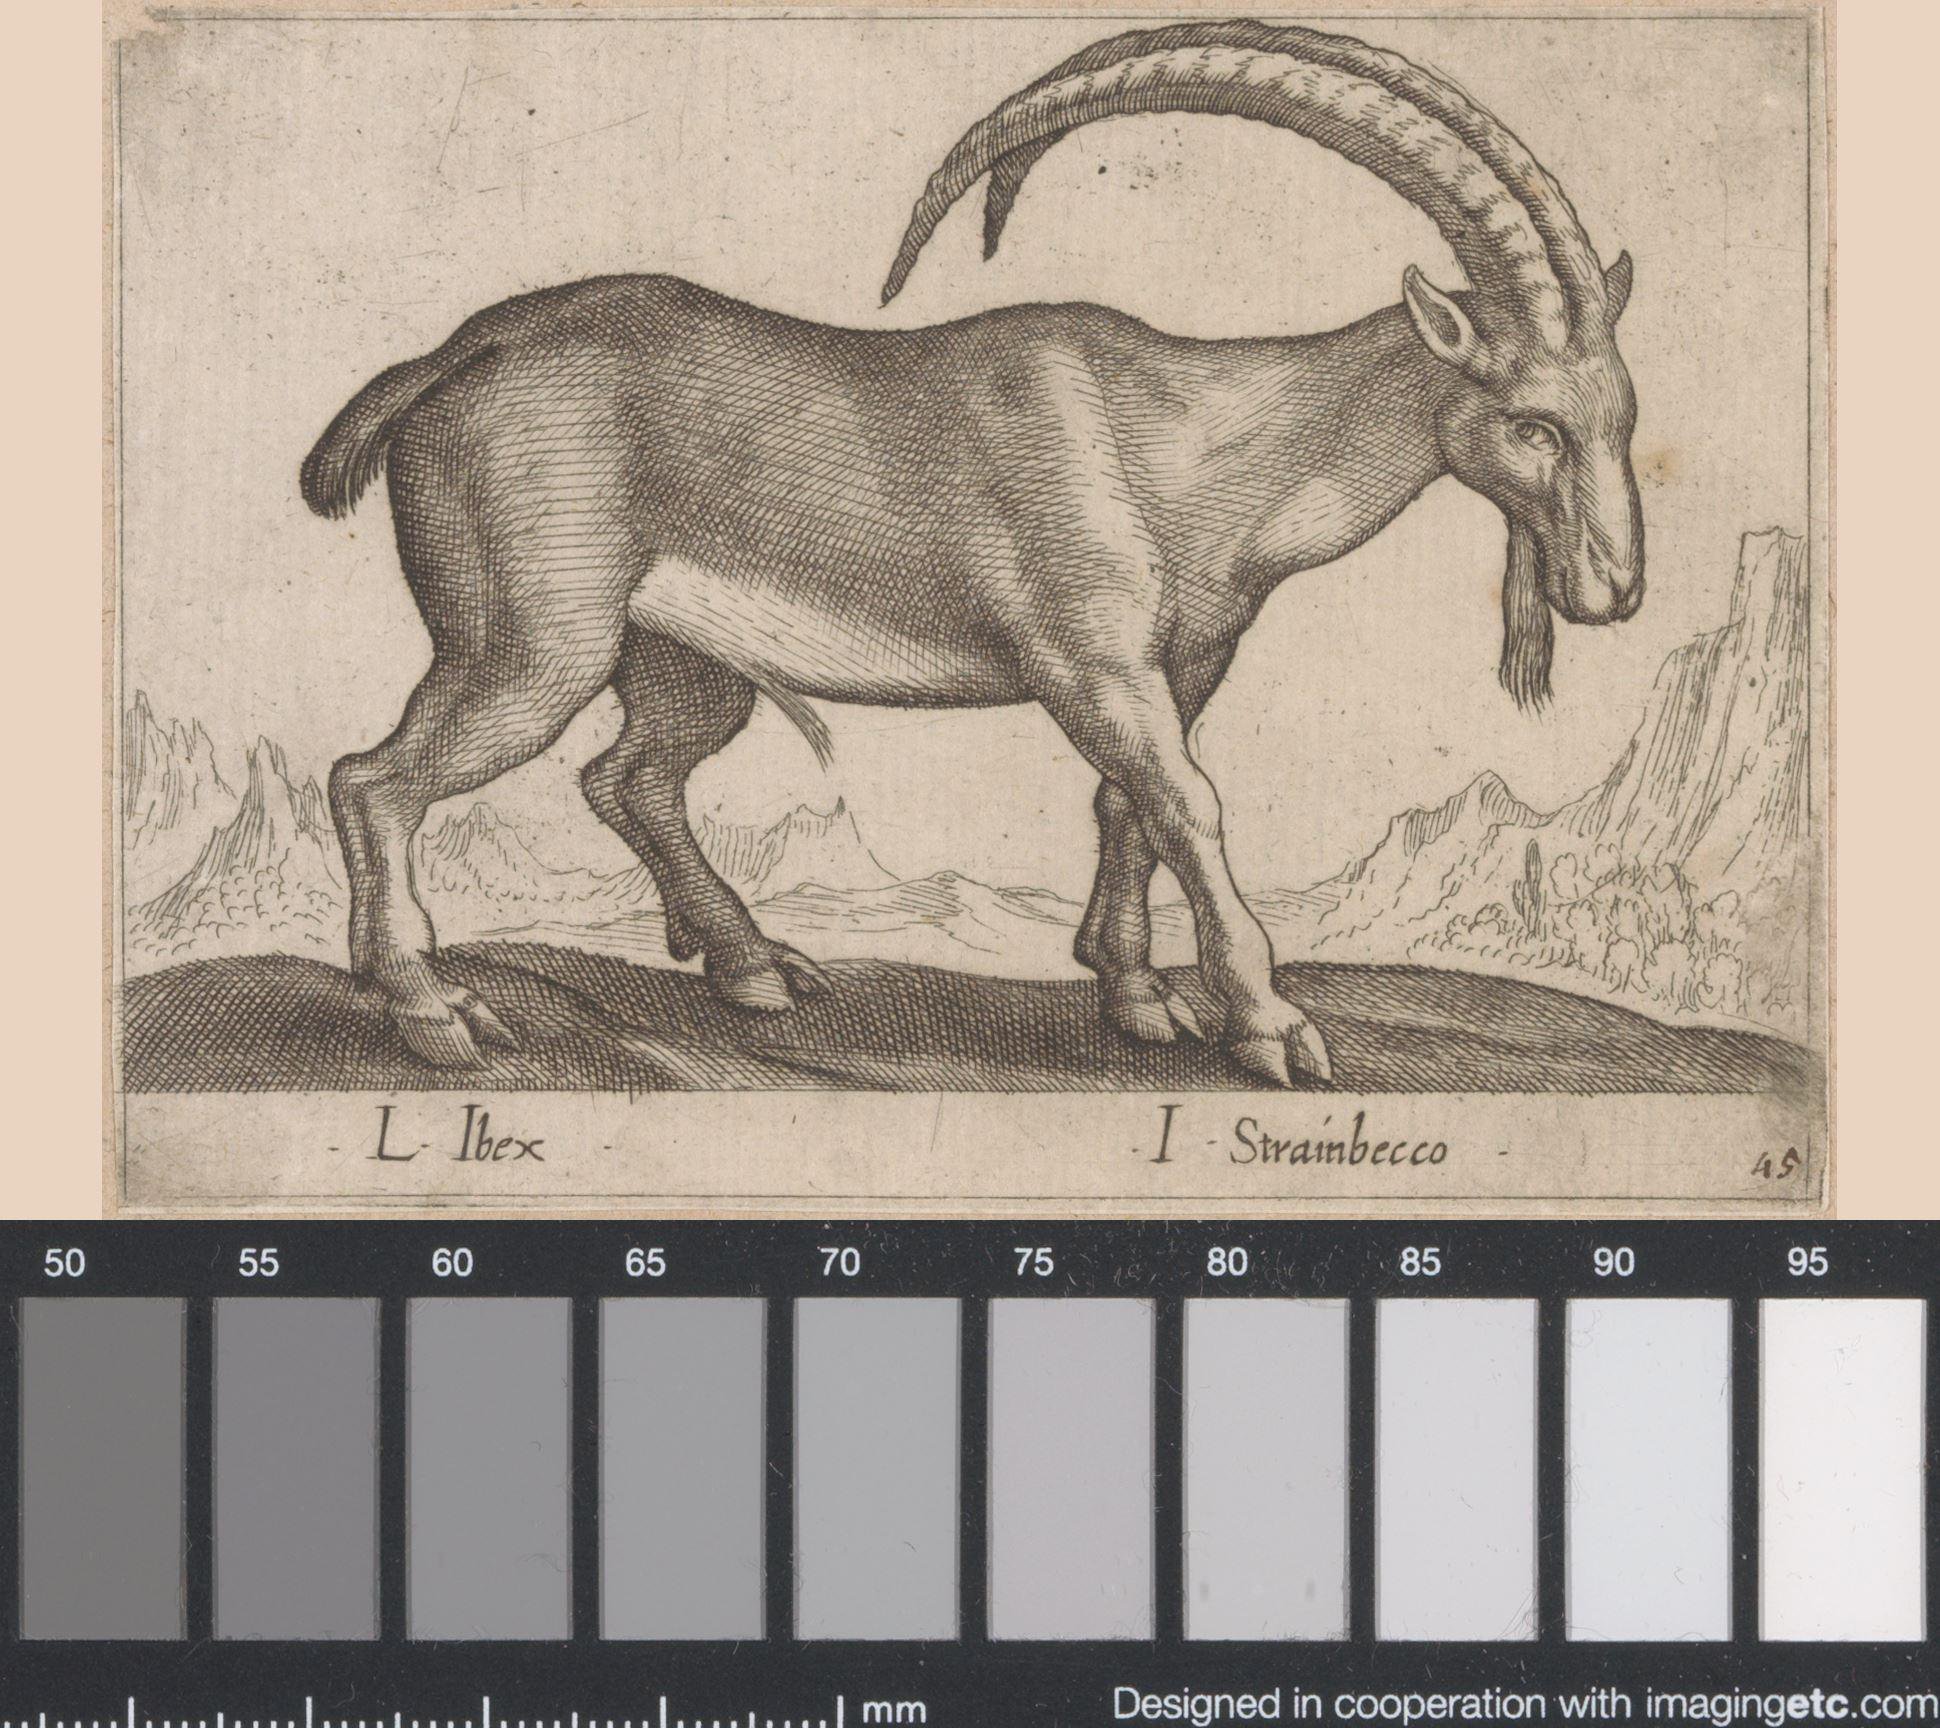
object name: print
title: Nova raccolta de li animali piu curiosi del mondo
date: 1565-1630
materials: paper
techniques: etching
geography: rome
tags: goat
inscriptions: collector's mark: Lugt 11, number: ‘45’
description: Deze prent maakt deel uit van een reeks prenten van dieren door Antonio Tempesta. Bekend is dat een tweede staat (met nummering) van deze serie is uitgegeven door Giovanni Giacomo de' Rossi in 1650. Onbekend is wie de eerste staat heeft uitgegeven en wanneer.